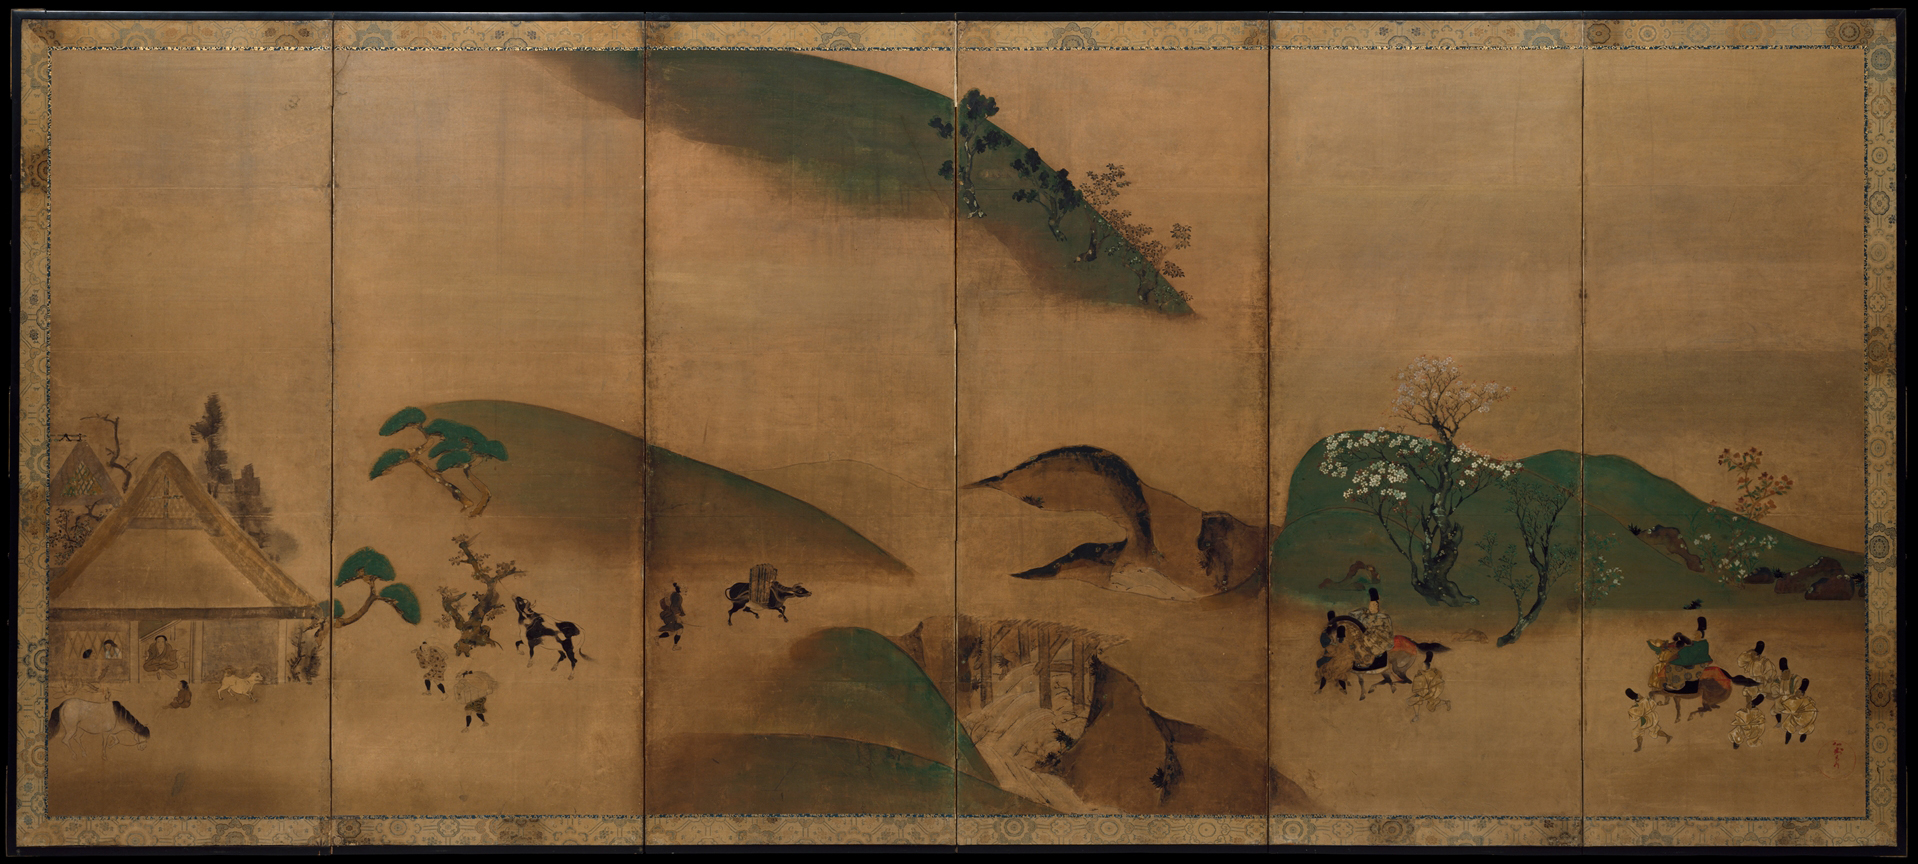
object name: screen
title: Royal Visit to Ōhara, from The Tale of the Heike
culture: japanese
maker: tawaraya sōtatsu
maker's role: artist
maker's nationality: japanese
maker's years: 1570-1640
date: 1601-1650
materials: ink, panel, paper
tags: human figures,houses,landscapes,trees